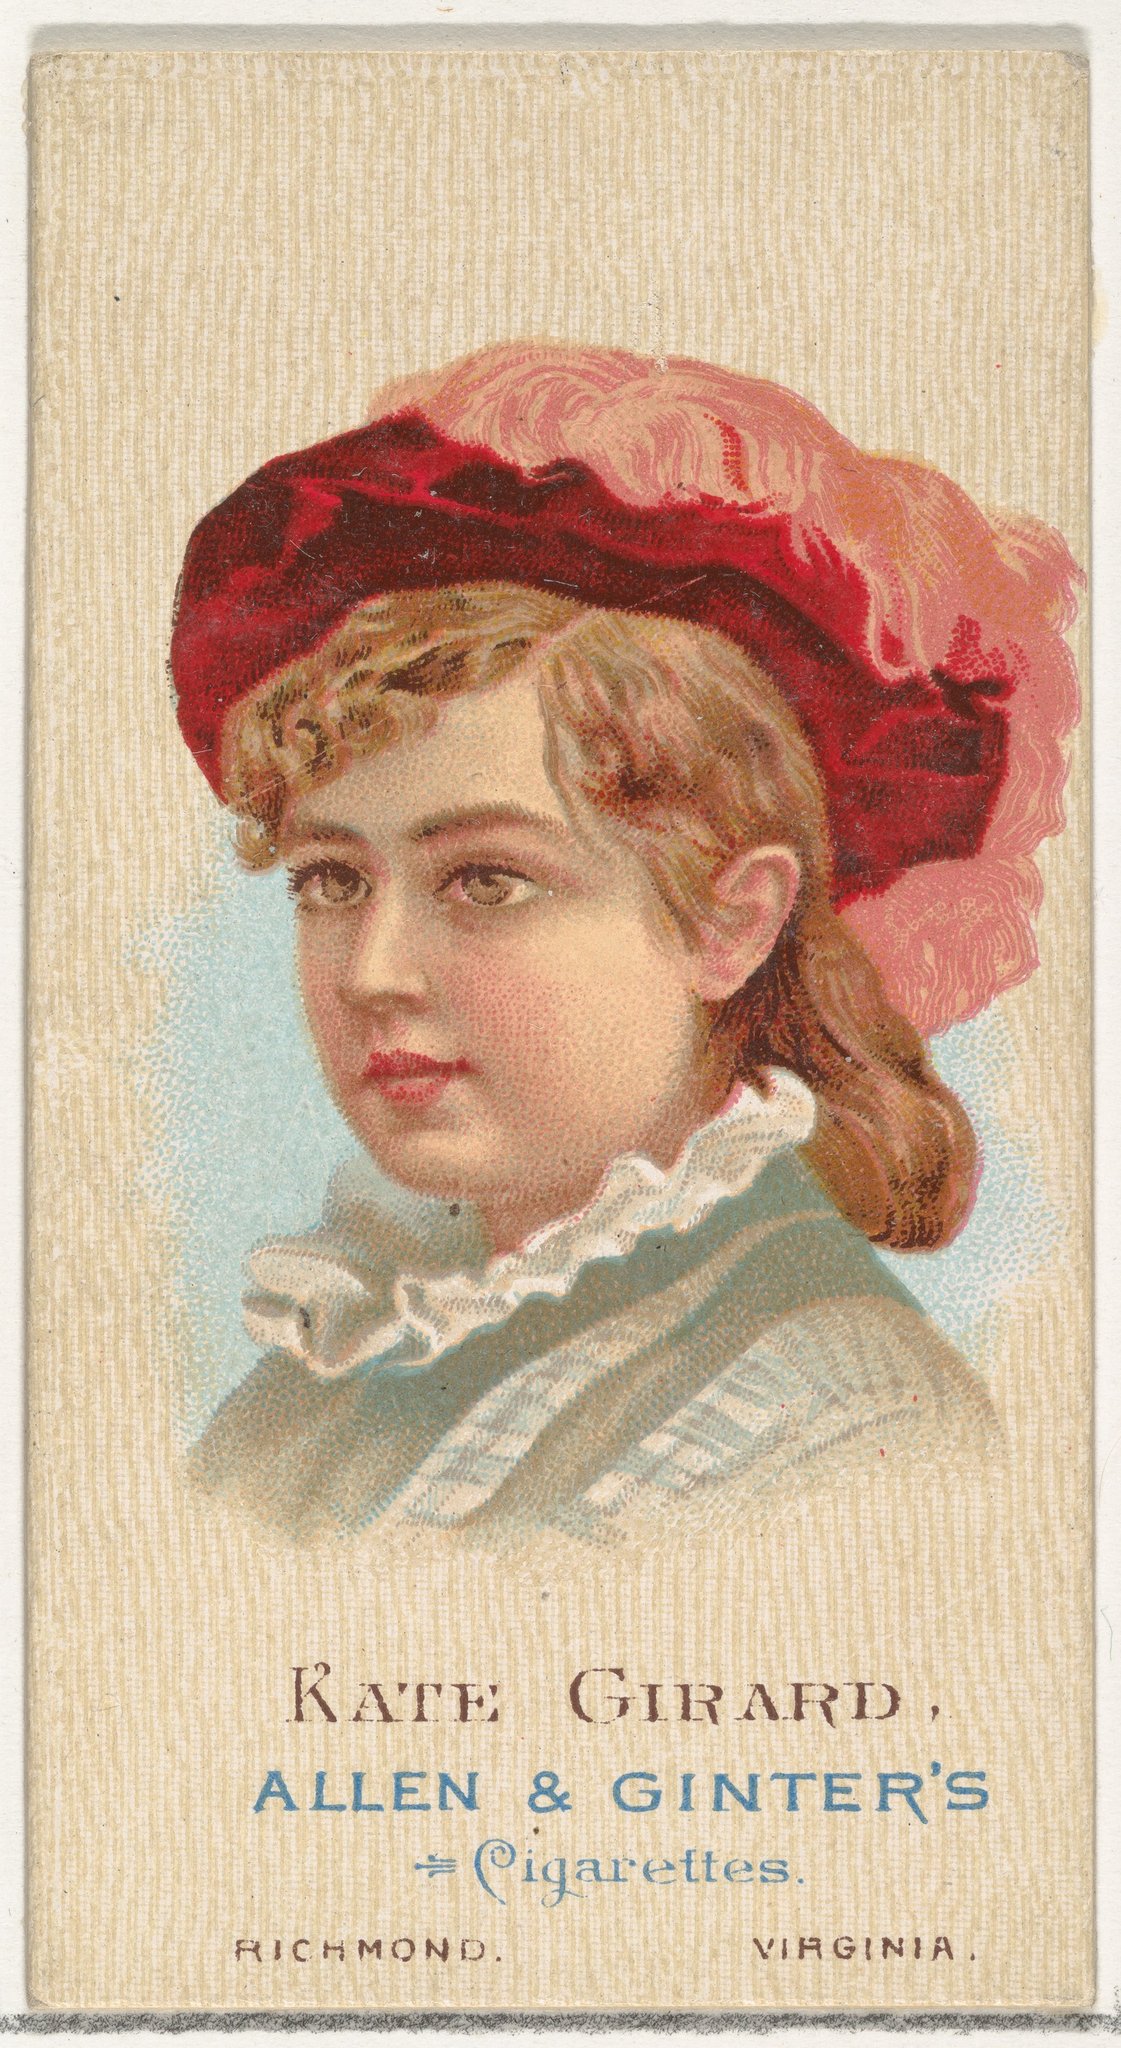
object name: print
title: Kate Girard, from World's Beauties, Series 2 (N27) for Allen & Ginter Cigarettes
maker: allen & ginter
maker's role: publisher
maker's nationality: american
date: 1888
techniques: color lithograph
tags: women